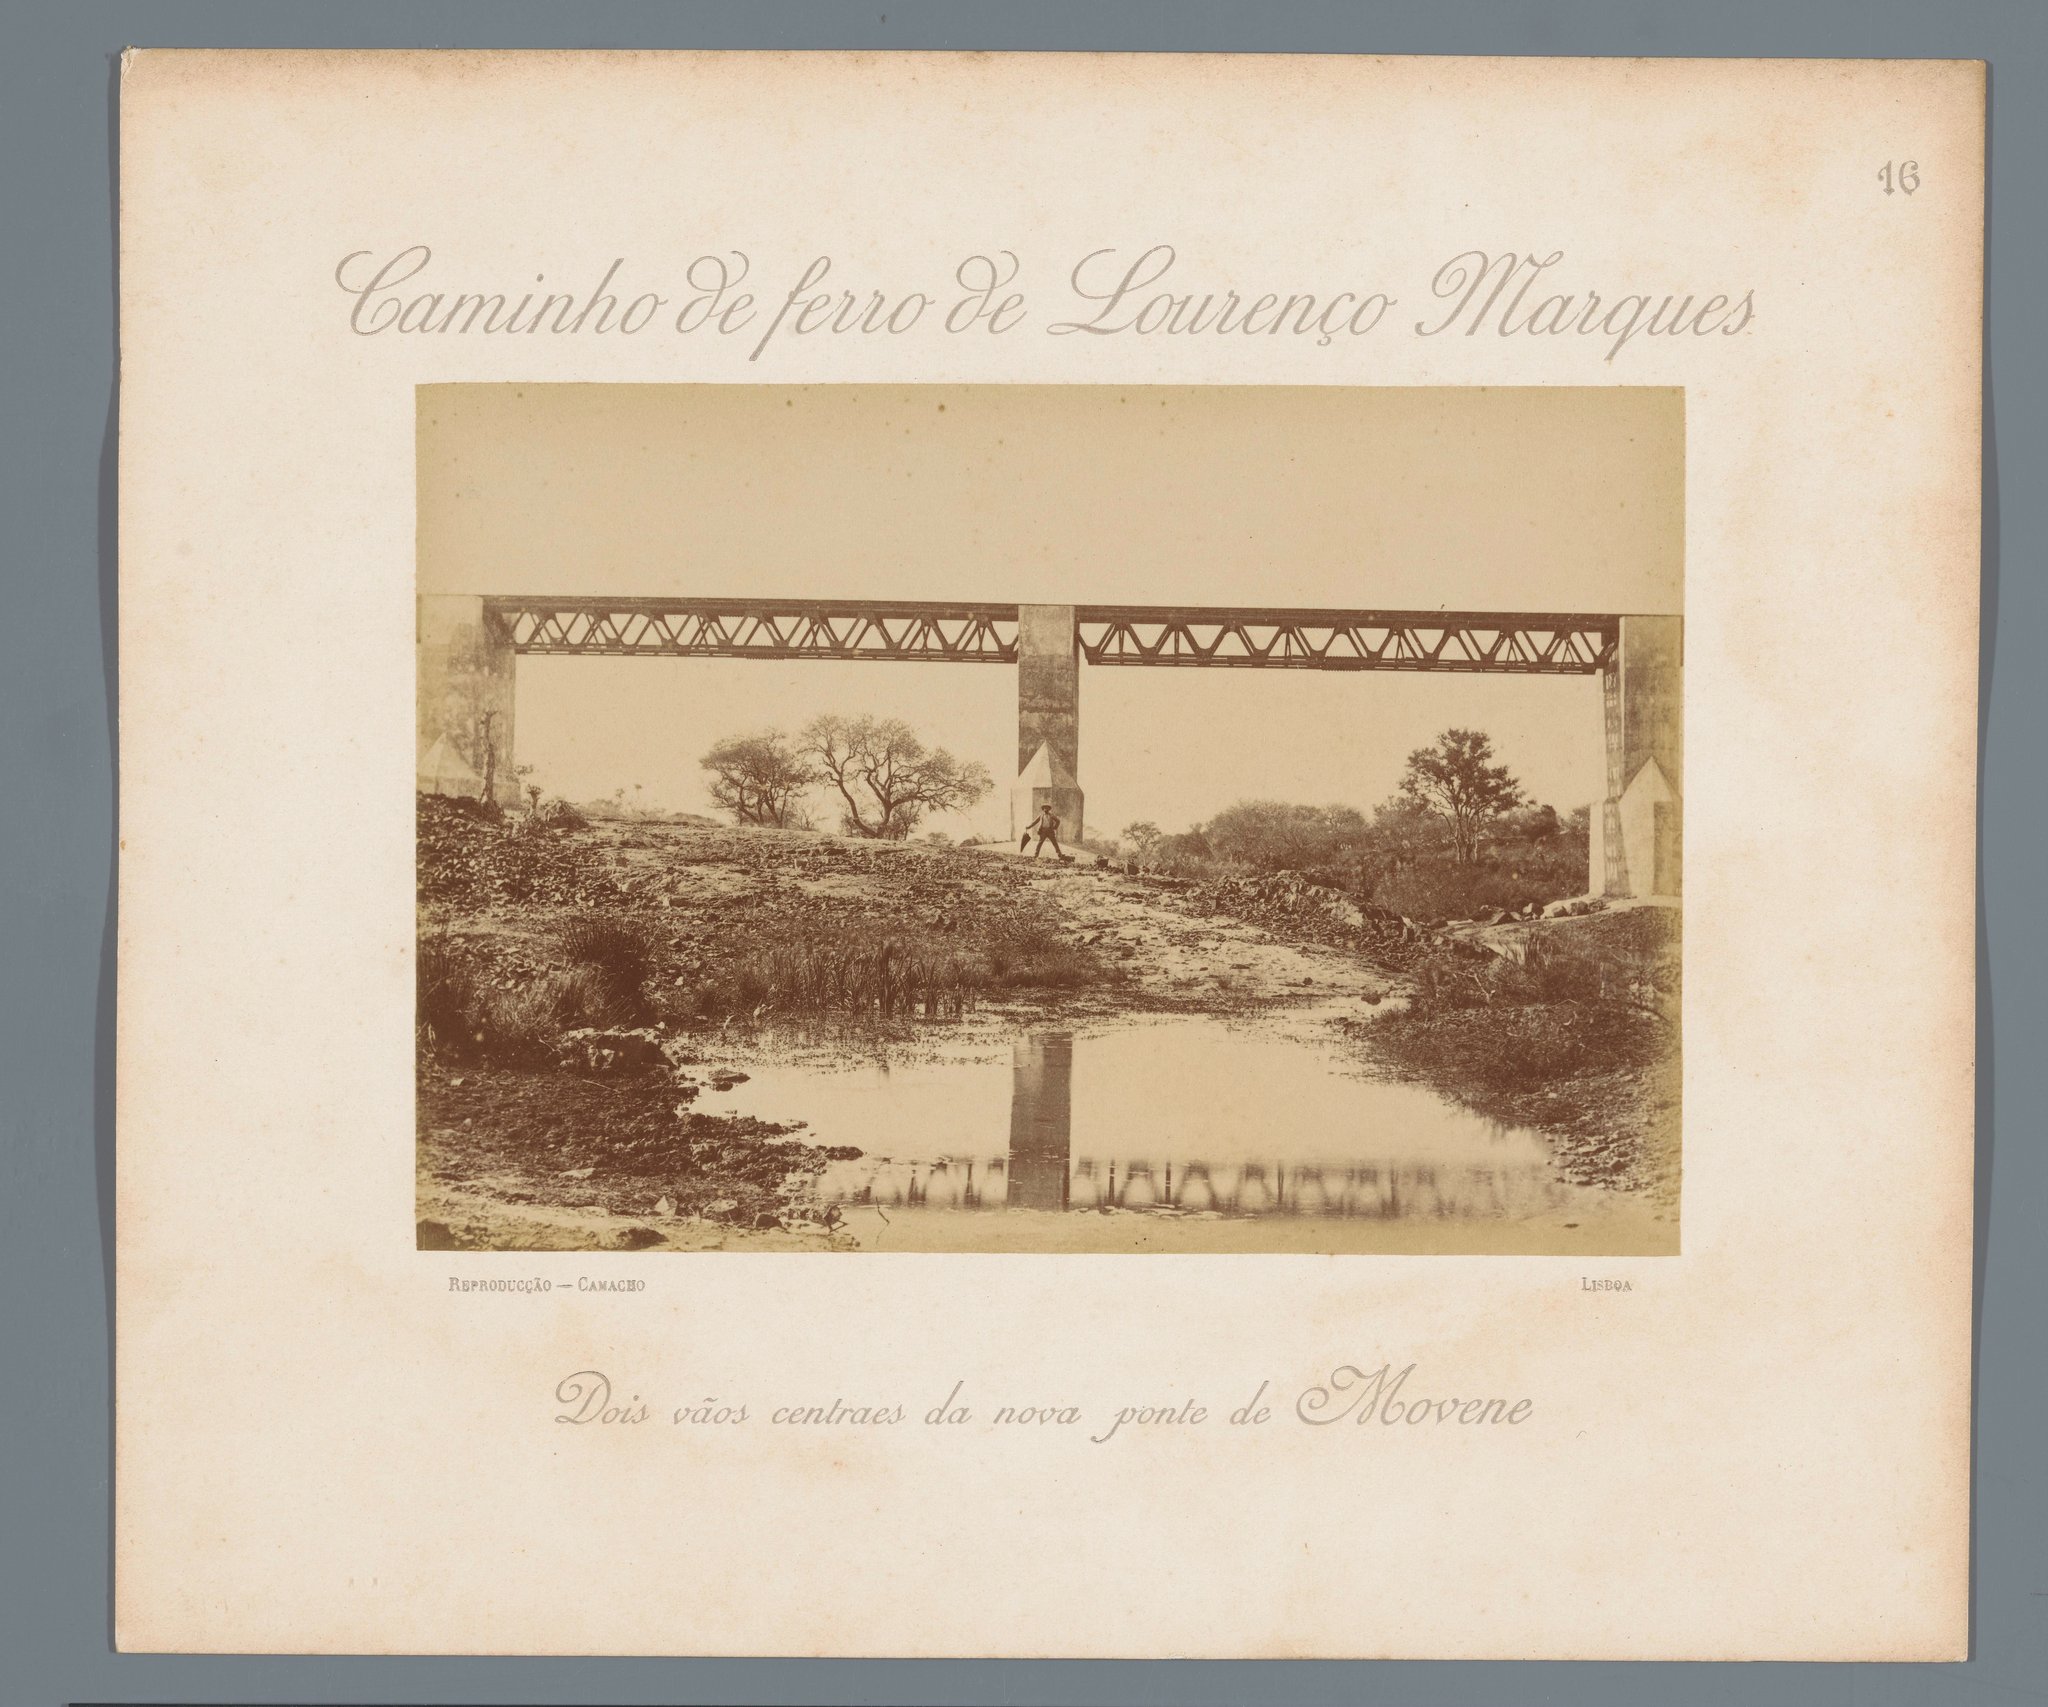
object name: photograph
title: Gezicht op een spoorbrug over de Rio Movene in Mozambique met een man ervoor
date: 1889-1895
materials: photographic support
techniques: albumen print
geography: mozambique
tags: landscape with bridge, viaduct or aqueduct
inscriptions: number: ‘16’